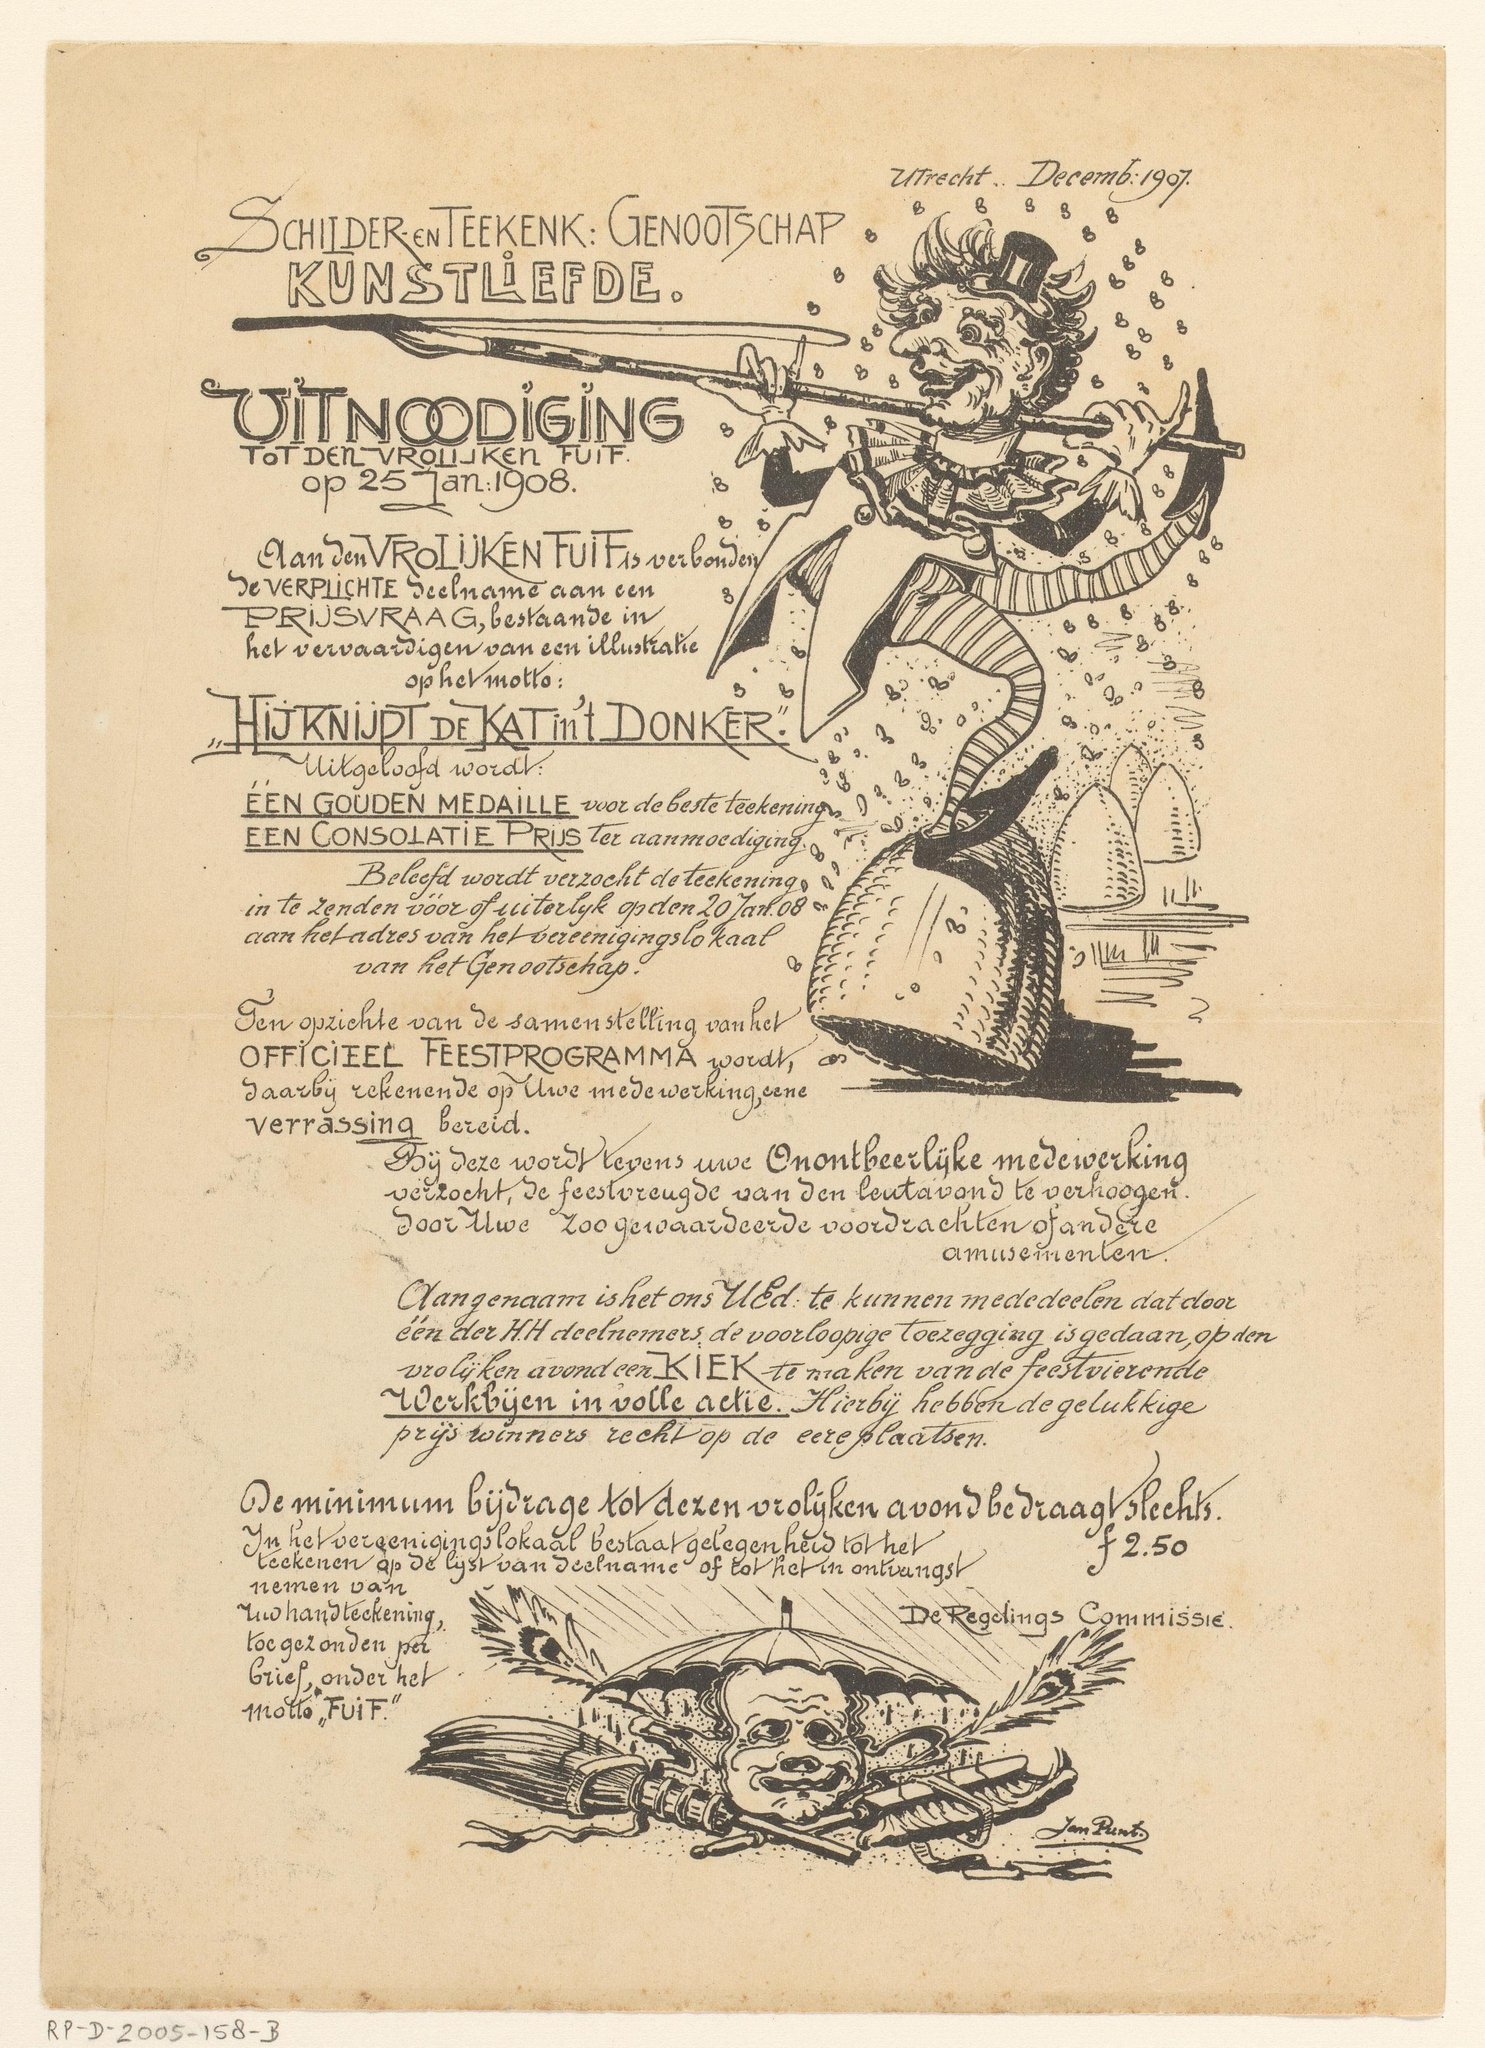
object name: invitation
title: Uitnodiging van Schilder- en Teekenkundig Genootschap "Kunstliefde" voor een fuif op 25 januari 1908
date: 1901-1908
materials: paper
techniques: lithograph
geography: utrecht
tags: criticizing and discussing art, art criticism, circle, club of artists, collecting and exhibiting products of the fine arts, acrobat ~ circus, bee-hive, clown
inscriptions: collector's mark: Lugt 2228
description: Acrobatische clown met penseel balancerend op een bijenkorf en trofee van feestartikelen waaronder een masker. Uitnodiging van Schilder- en Teekenkundig Genootschap "Kunstliefde" voor een feest op 25 januari 1908.